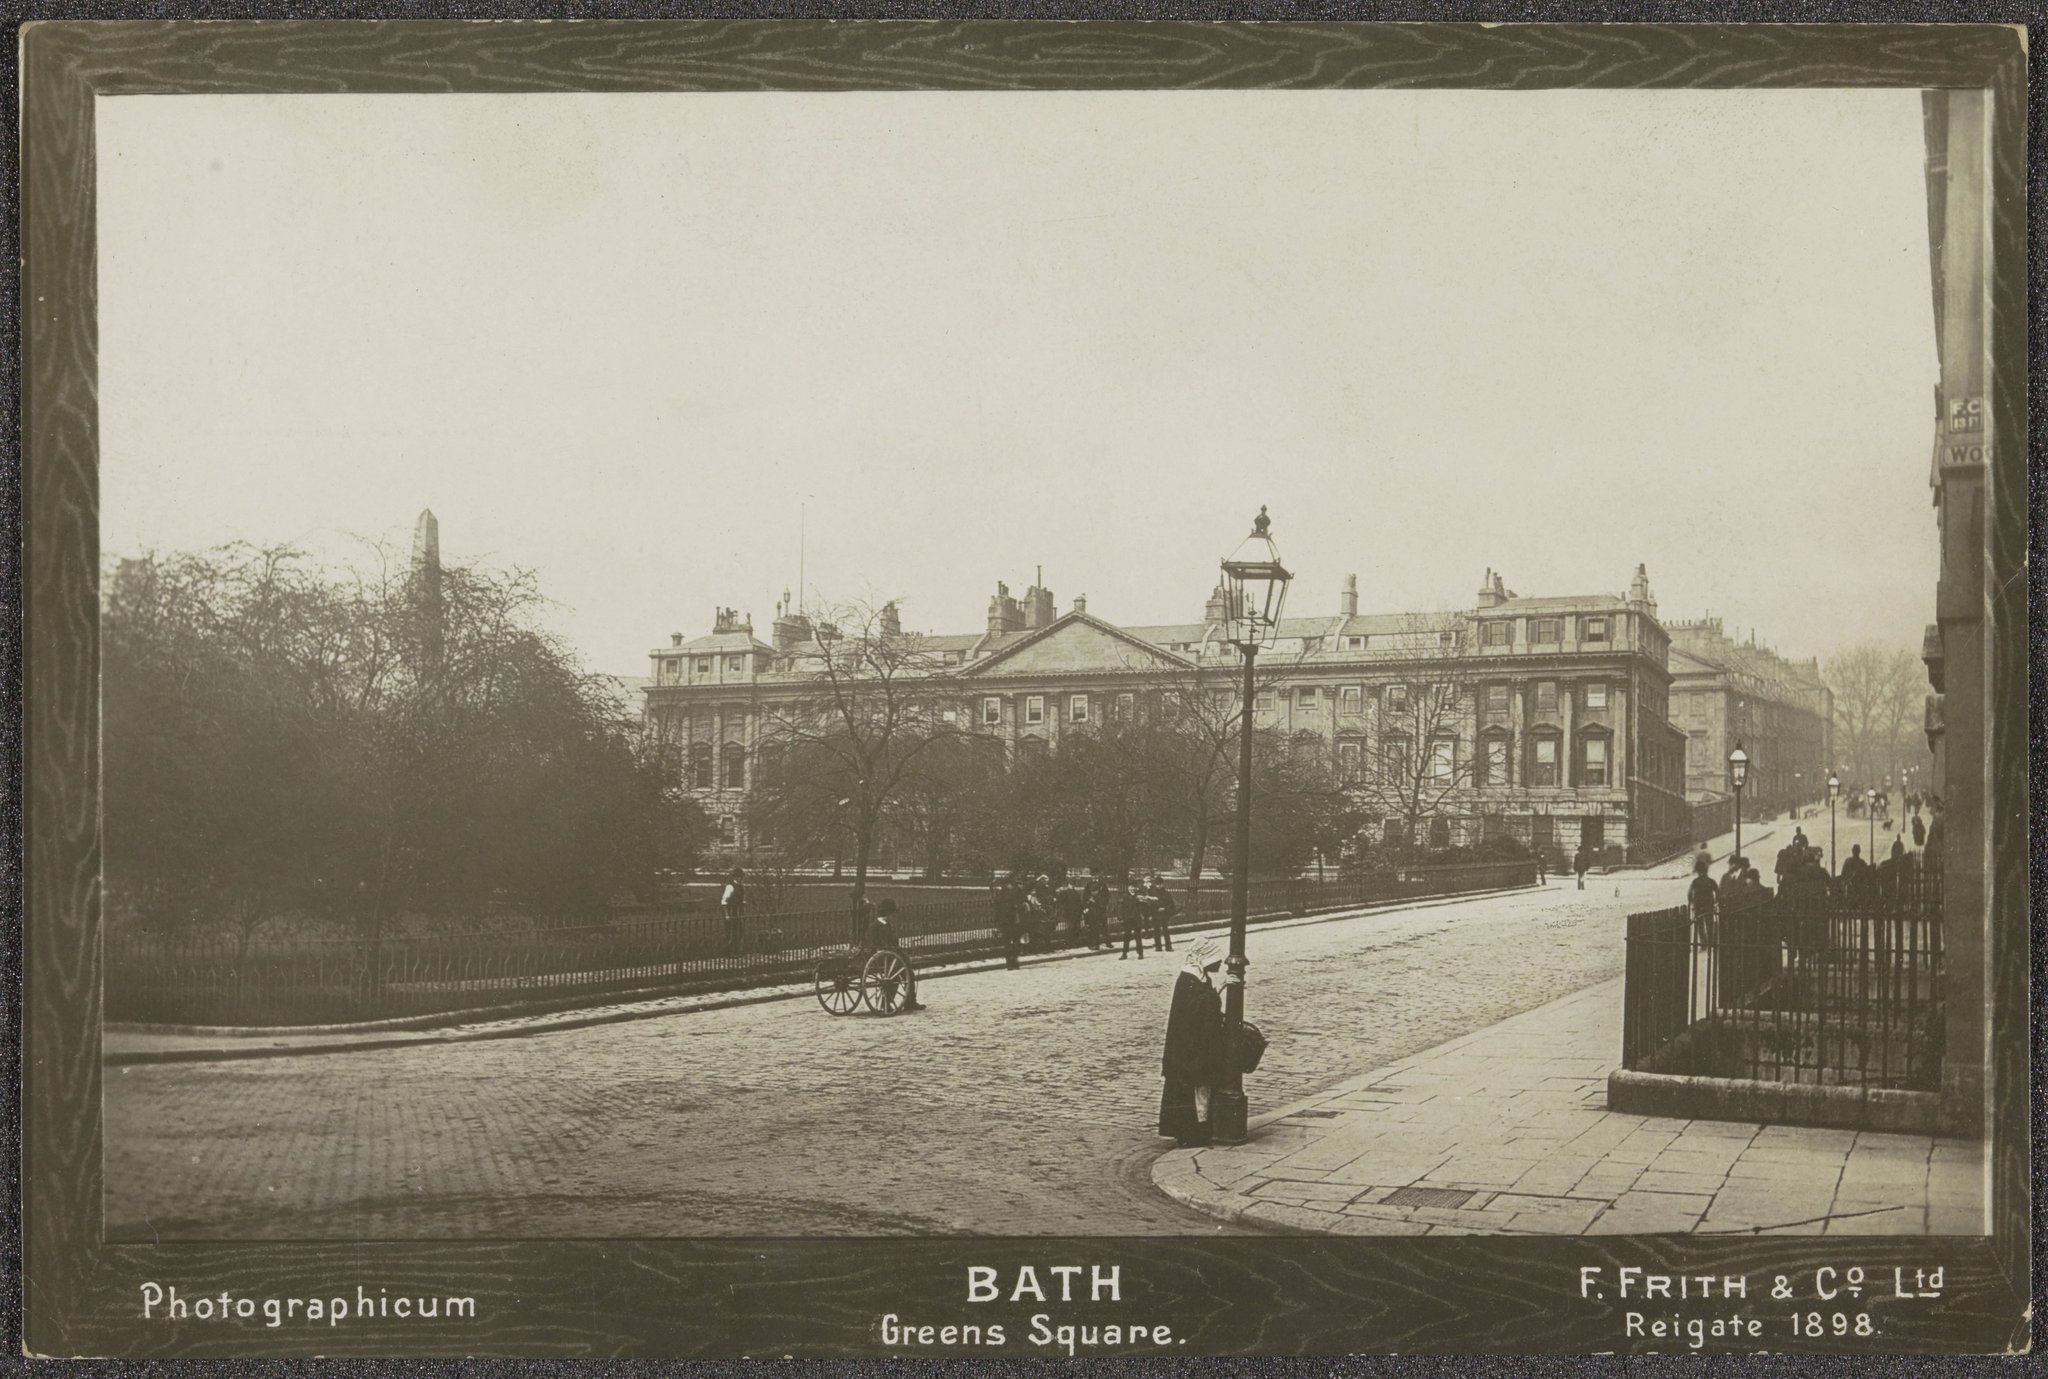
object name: photograph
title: Bath Greens Square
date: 1870-1898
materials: photographic support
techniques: gelatin silver print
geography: bath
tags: travelling; tourism, square, place, circus, etc. (+ city(-scape) with figures, staffage)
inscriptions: inscription: ‘Reigate 1898’, inscription: ‘Photographicum’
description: Foto hoort bij een serie van 28 losse prentbriefkaarten van Engeland, Noorwegen, Italië, Duitsland en Tirol (foto's RP-F-F00945-1 t/m RP-F-F00945-28).